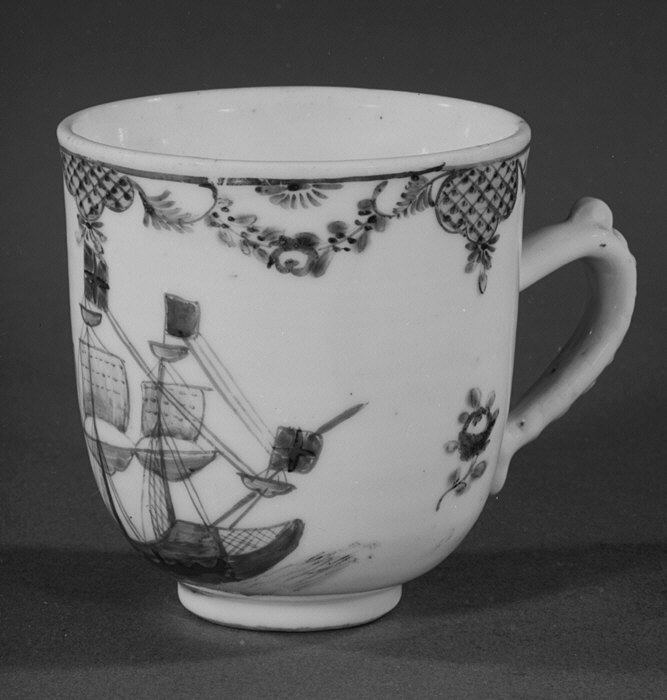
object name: cup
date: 1780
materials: hard paste porcelain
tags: ships